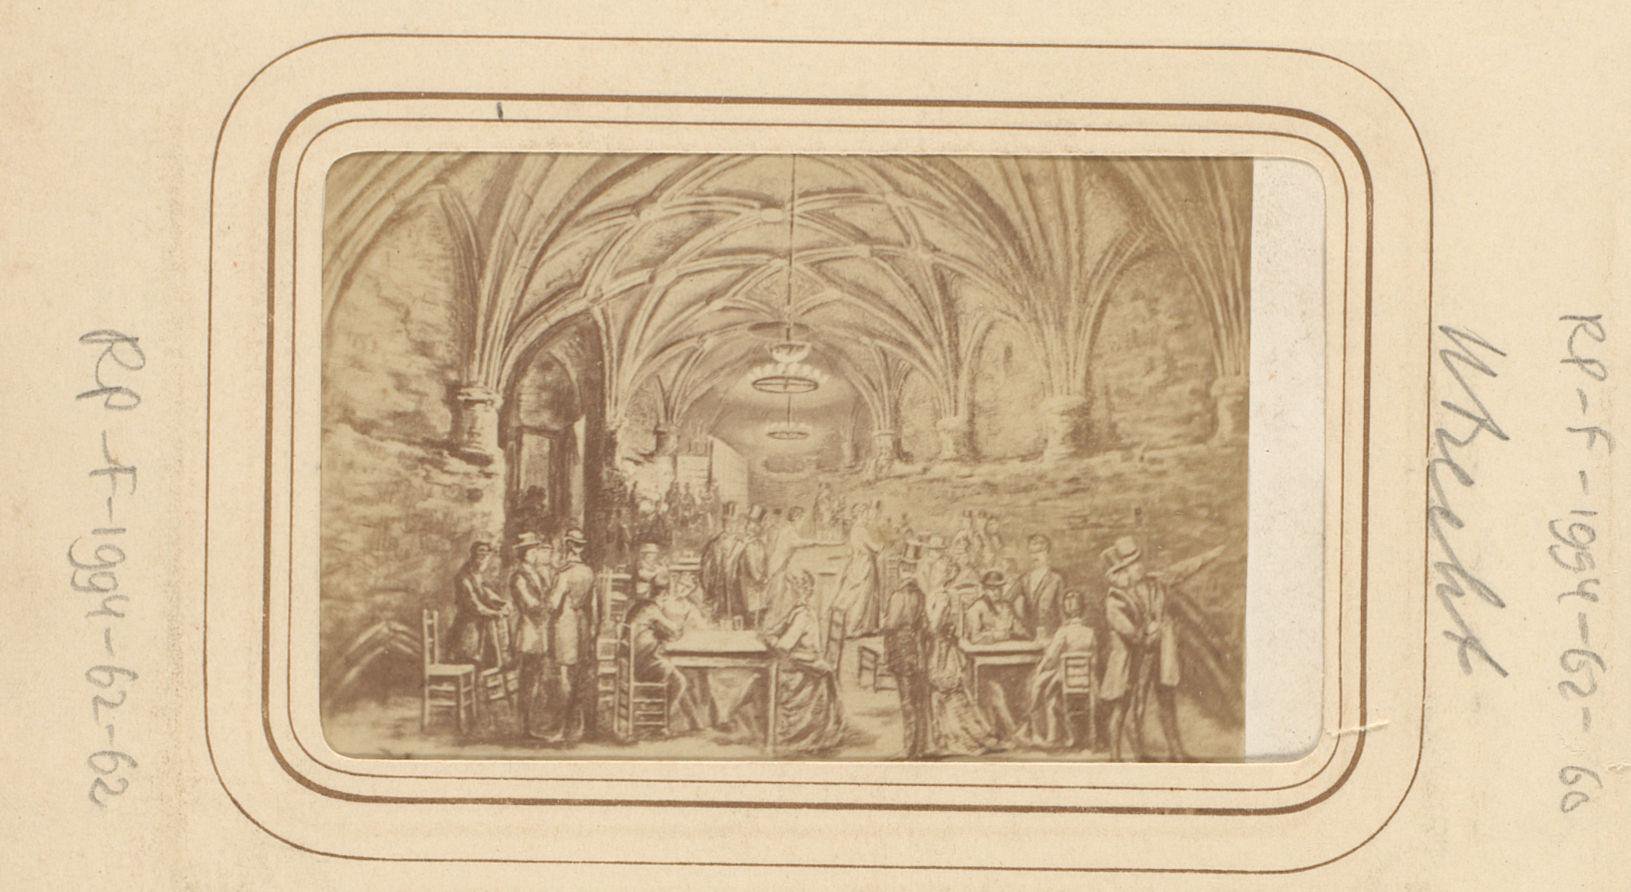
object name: reproduction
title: Fotoreproductie van tekening van een interieur met gezelschap aan tafels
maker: willem cornelis van dijk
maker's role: painter, print maker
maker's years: 1826-1881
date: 1860-1875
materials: cardboard, photographic support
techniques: albumen print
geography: utrecht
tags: graphic artist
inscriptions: inscription: ‘W.C. van Dijk / Artiste-peintre/ et/ Photographe de S.M. le Roi. / Utrecht / Langenieuwstraat / Lett. A, No. 522.’